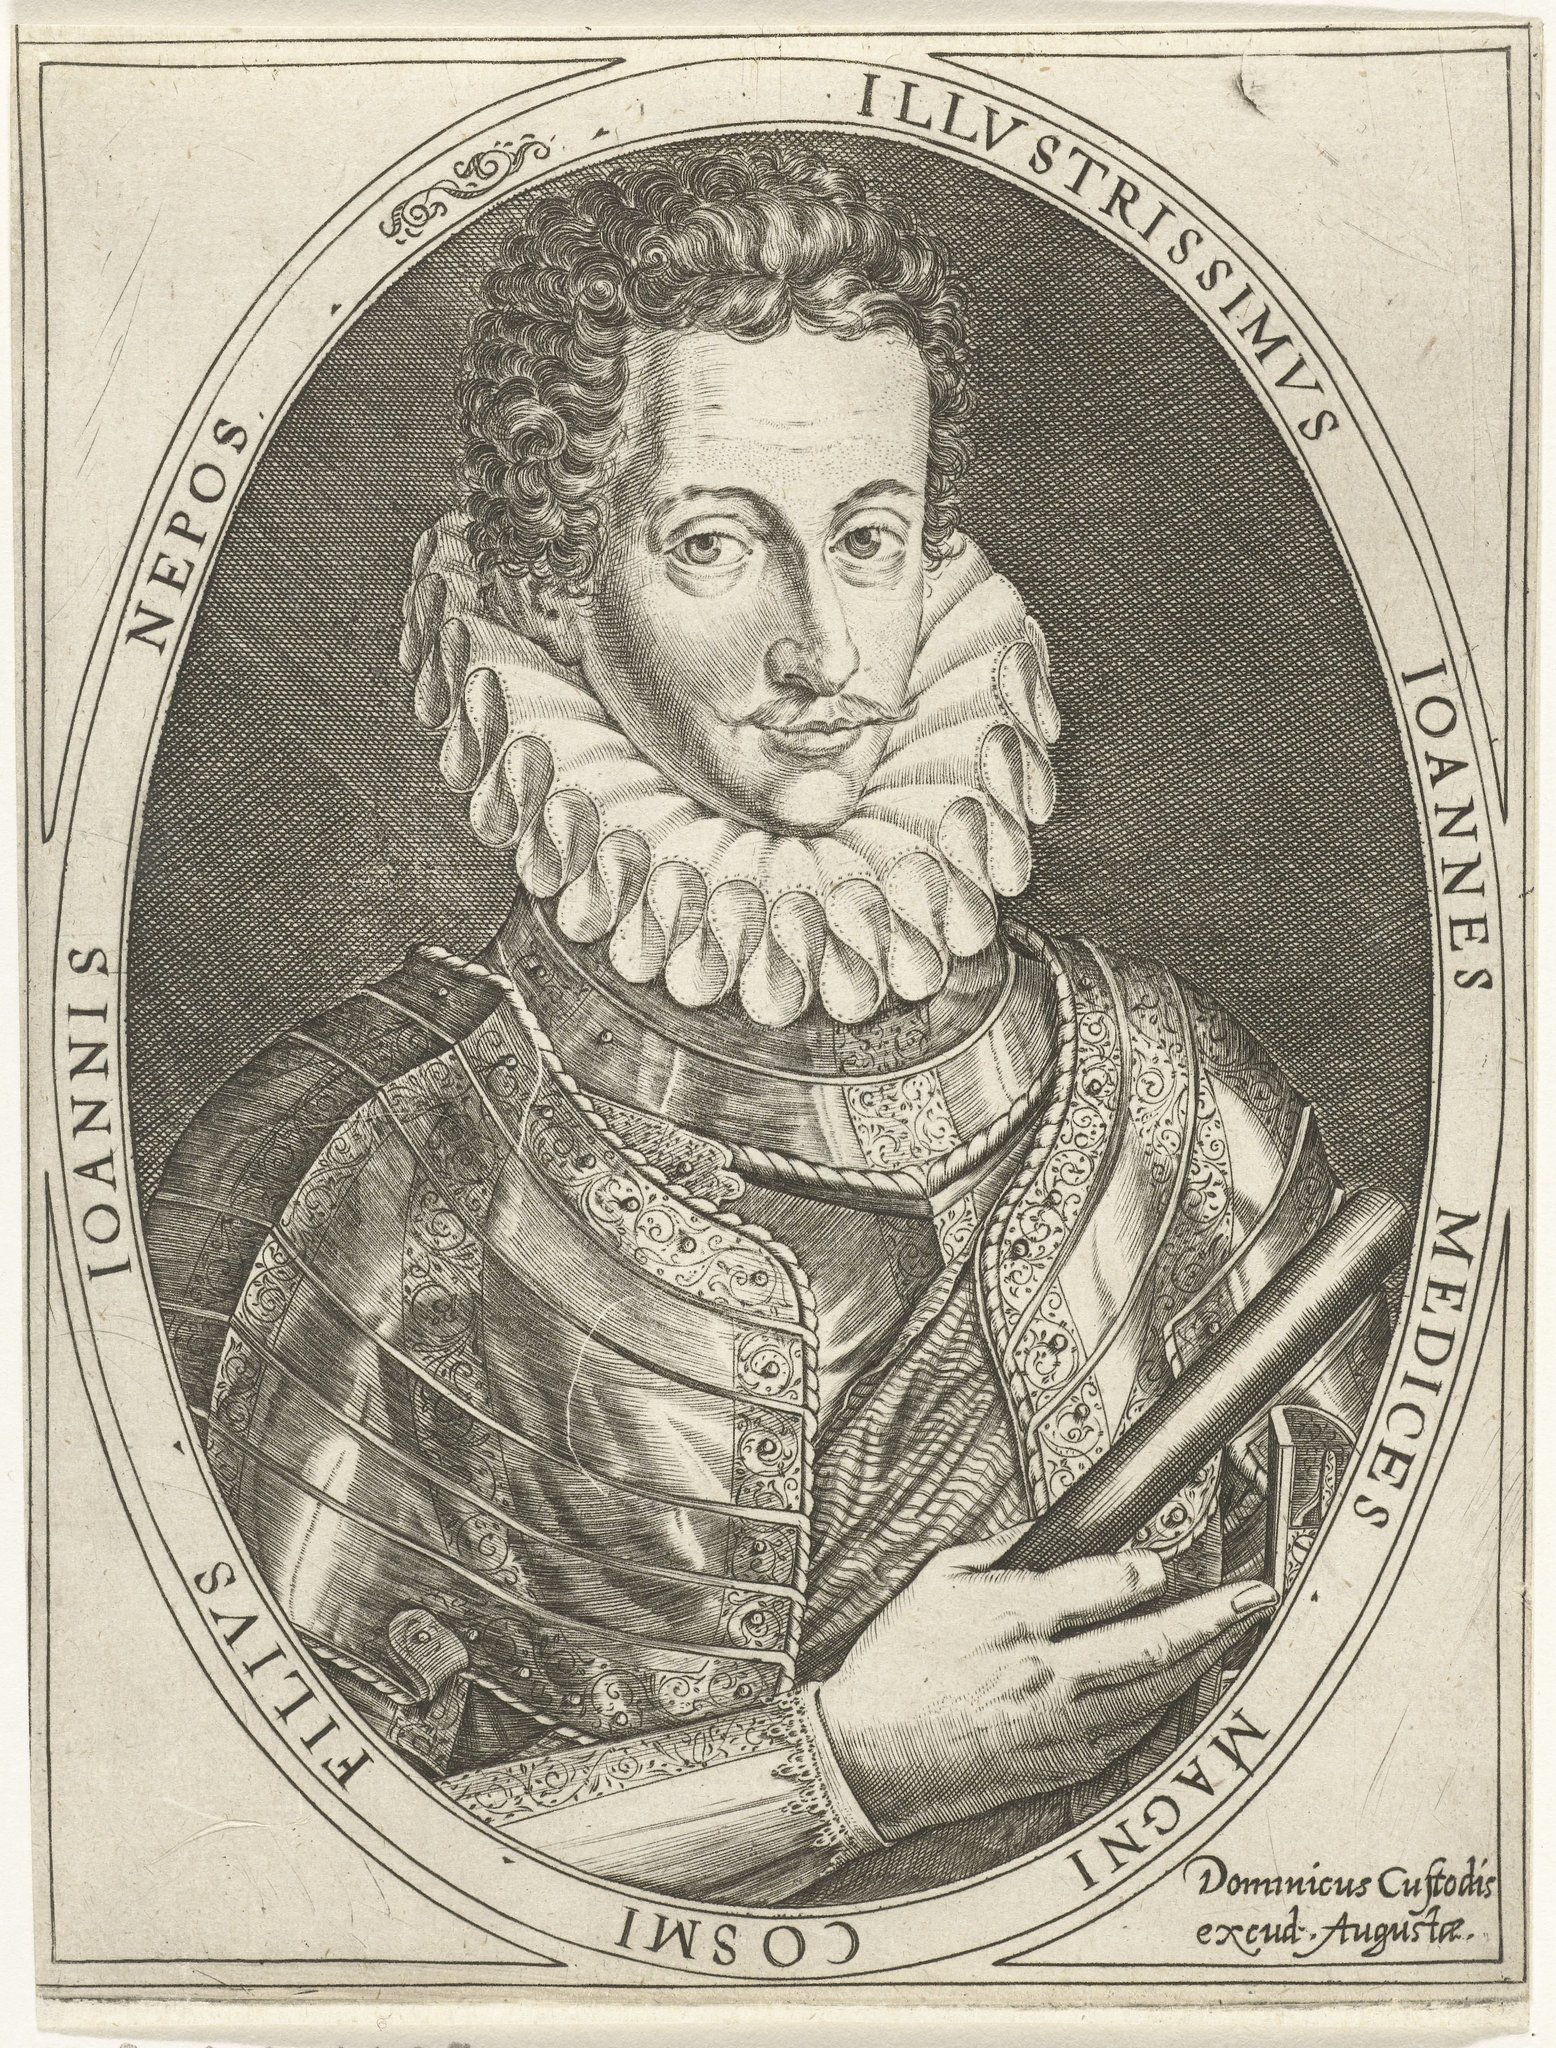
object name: print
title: Portretten van bekende personen uit de zestiende eeuw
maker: dominicus custos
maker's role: print maker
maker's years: 1560-1615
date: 1600-1604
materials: paper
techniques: engraving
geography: augsburg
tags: militair, giovanni de' medici (-1621)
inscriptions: collector's mark: Lugt 2228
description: Illustratie uit: D. Custos en M. Henning. Atrium heroicum Caesarum, regum aliorq. summatum ac procerum qui intra proximum seculum vixere, aut hodie supersunt, imaginib. Deel 1-4. Augsburg: D. Custos, 1600-1604.